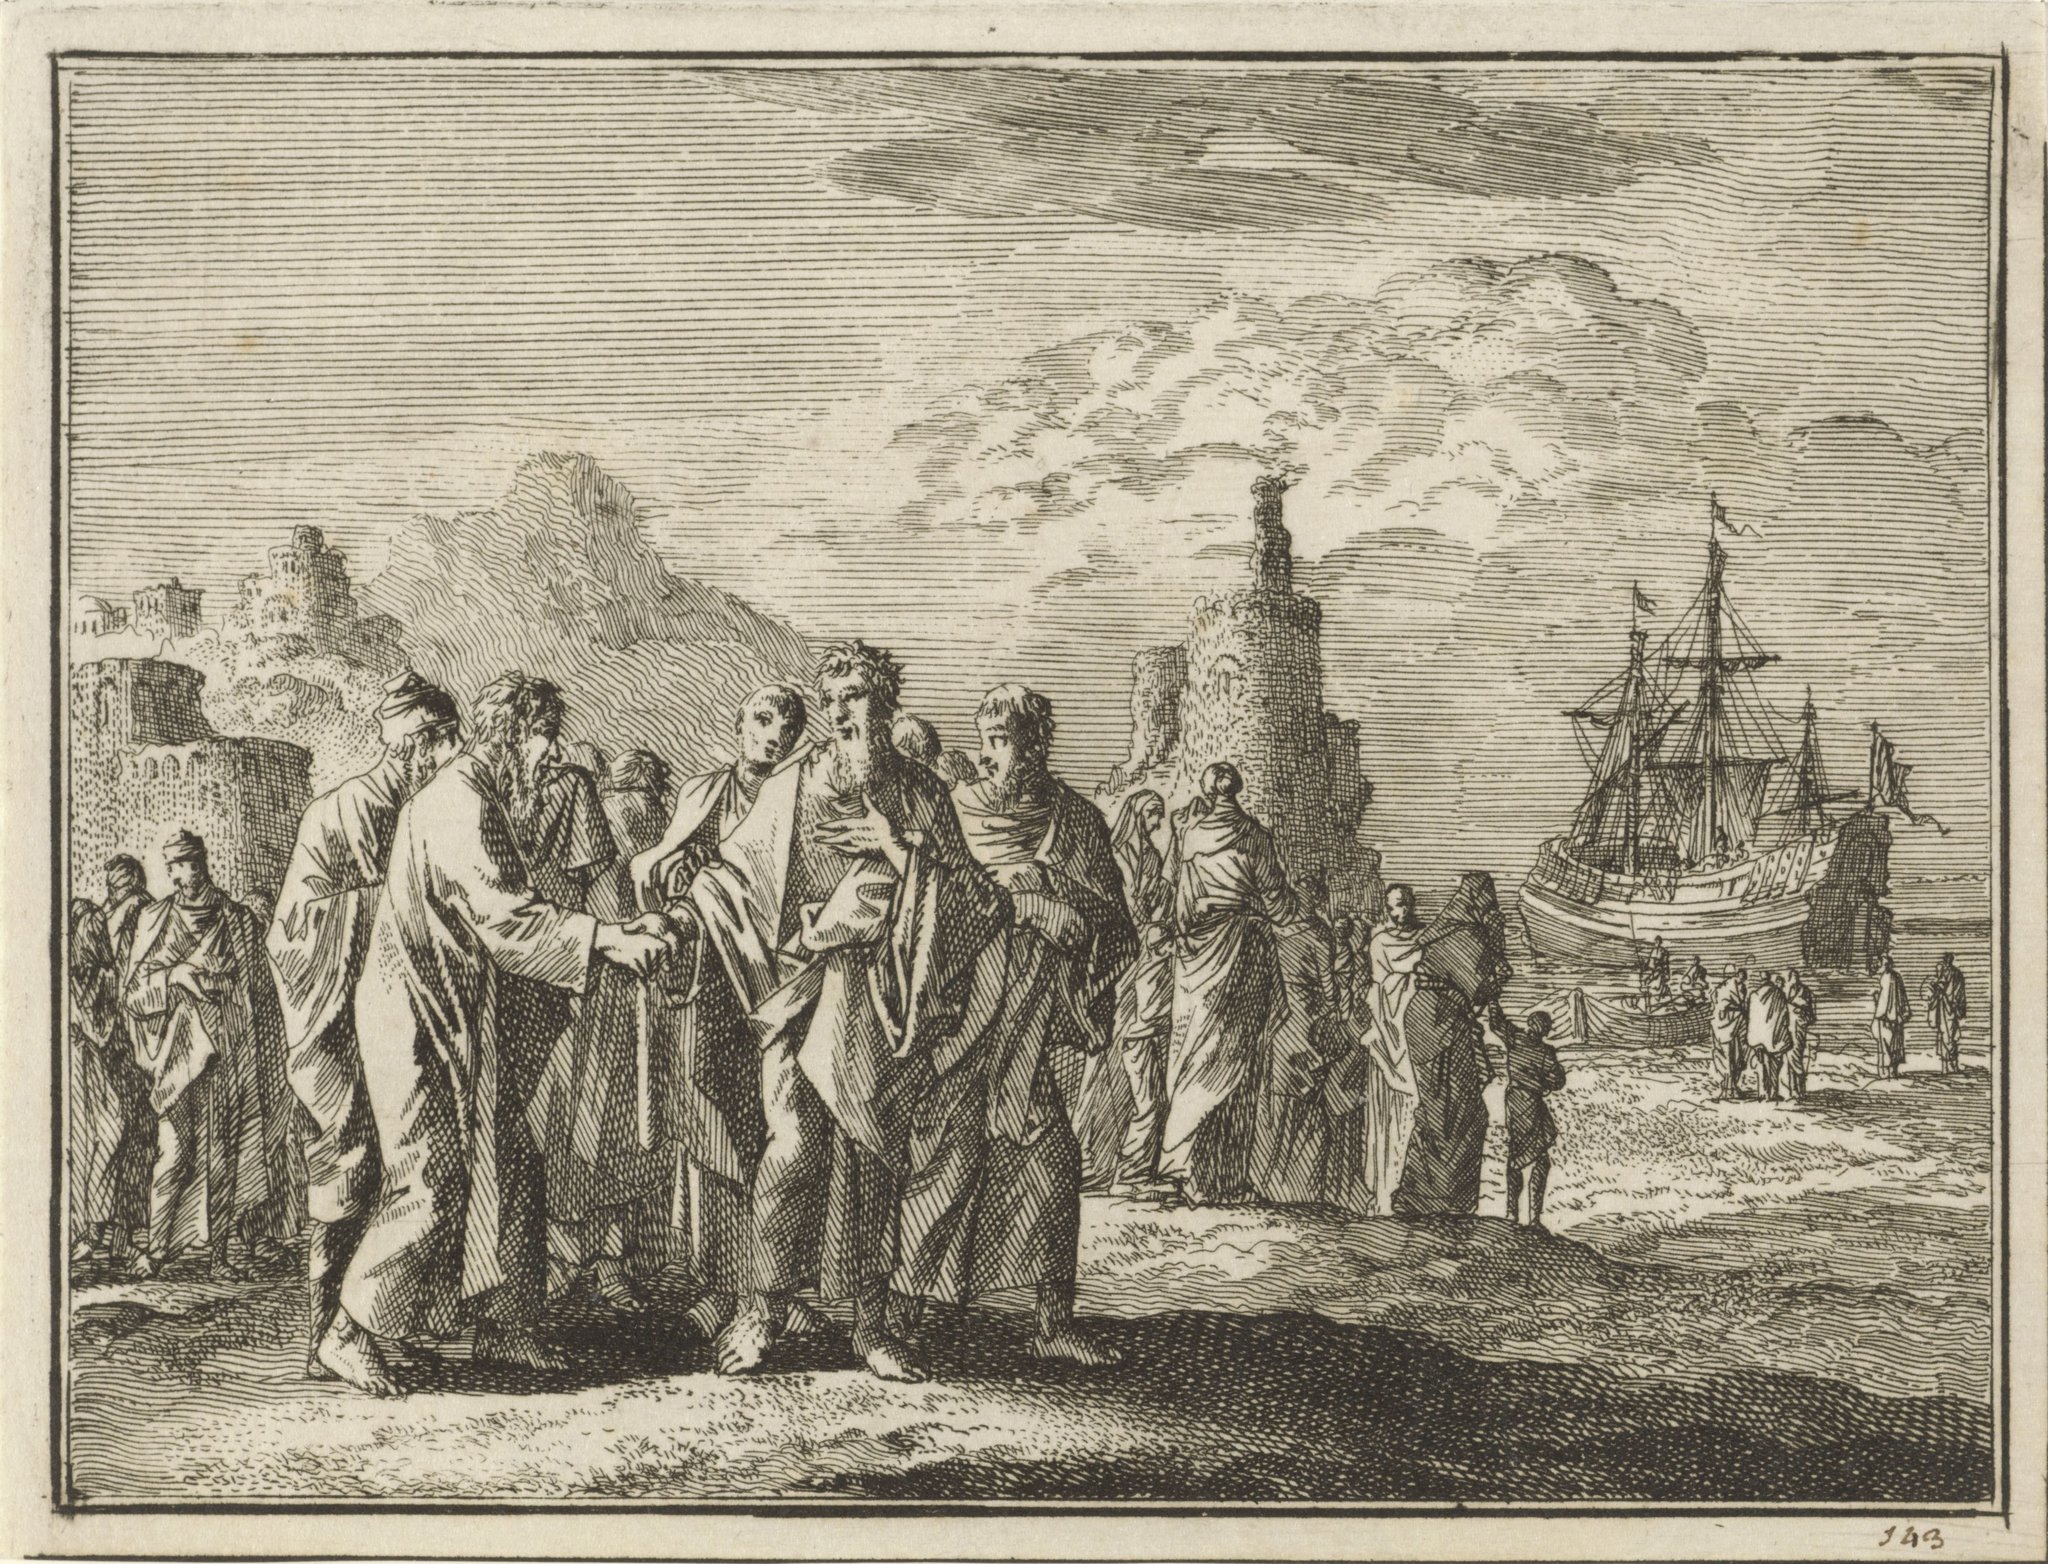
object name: print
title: Paulus neemt afscheid van de ouderlingen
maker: jan luyken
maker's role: draughtsman, print maker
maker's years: 1649-1712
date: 1712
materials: paper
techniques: etching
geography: amsterdam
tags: paul's farewell speech to the elders of ephesus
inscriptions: collector's mark: Lugt 2228, number: ‘143’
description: Proefdruk van illustratie uit: Luyken, Jan. De schriftuurlyke geschiedenissen en gelykenissen van het Oude en Nieuwe Verbond, 2 delen. Amsterdam: Wed. Pieter Arentsz II en Cornelis van der Sys, 1712, dl. II.